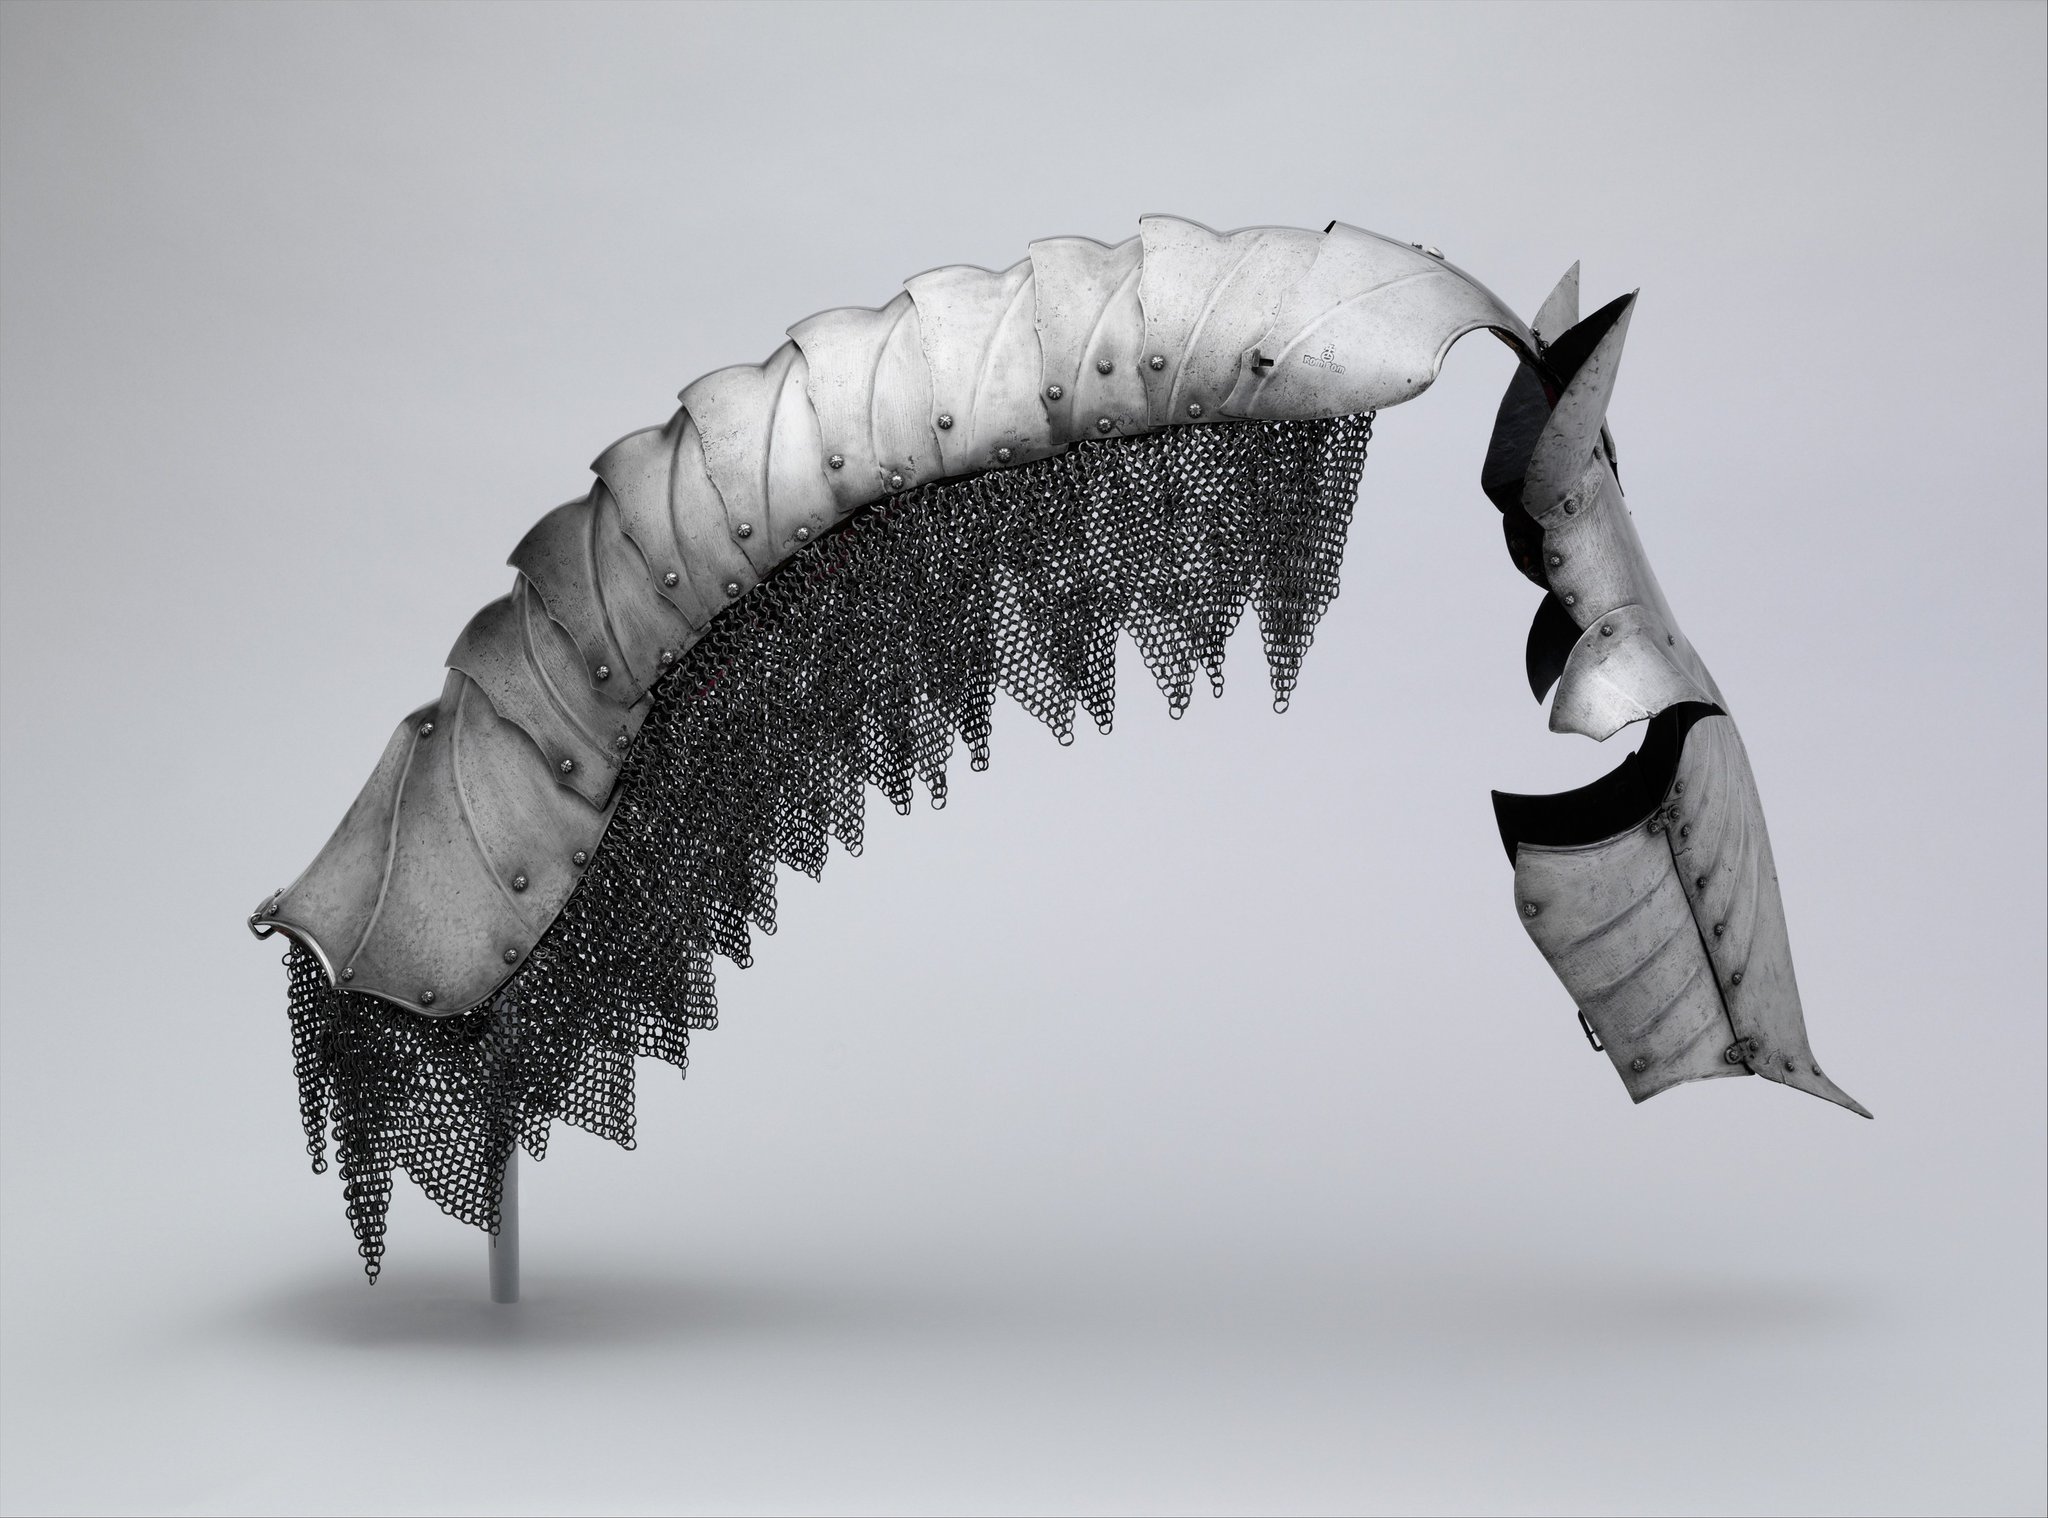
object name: shaffron and crinet horse's head and neck defense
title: Shaffron and Crinet (Horse's Head and Neck Defenses)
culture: franco-italian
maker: romain des ursins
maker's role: armorer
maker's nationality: italian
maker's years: 1493-1495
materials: steel, textile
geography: france or italy